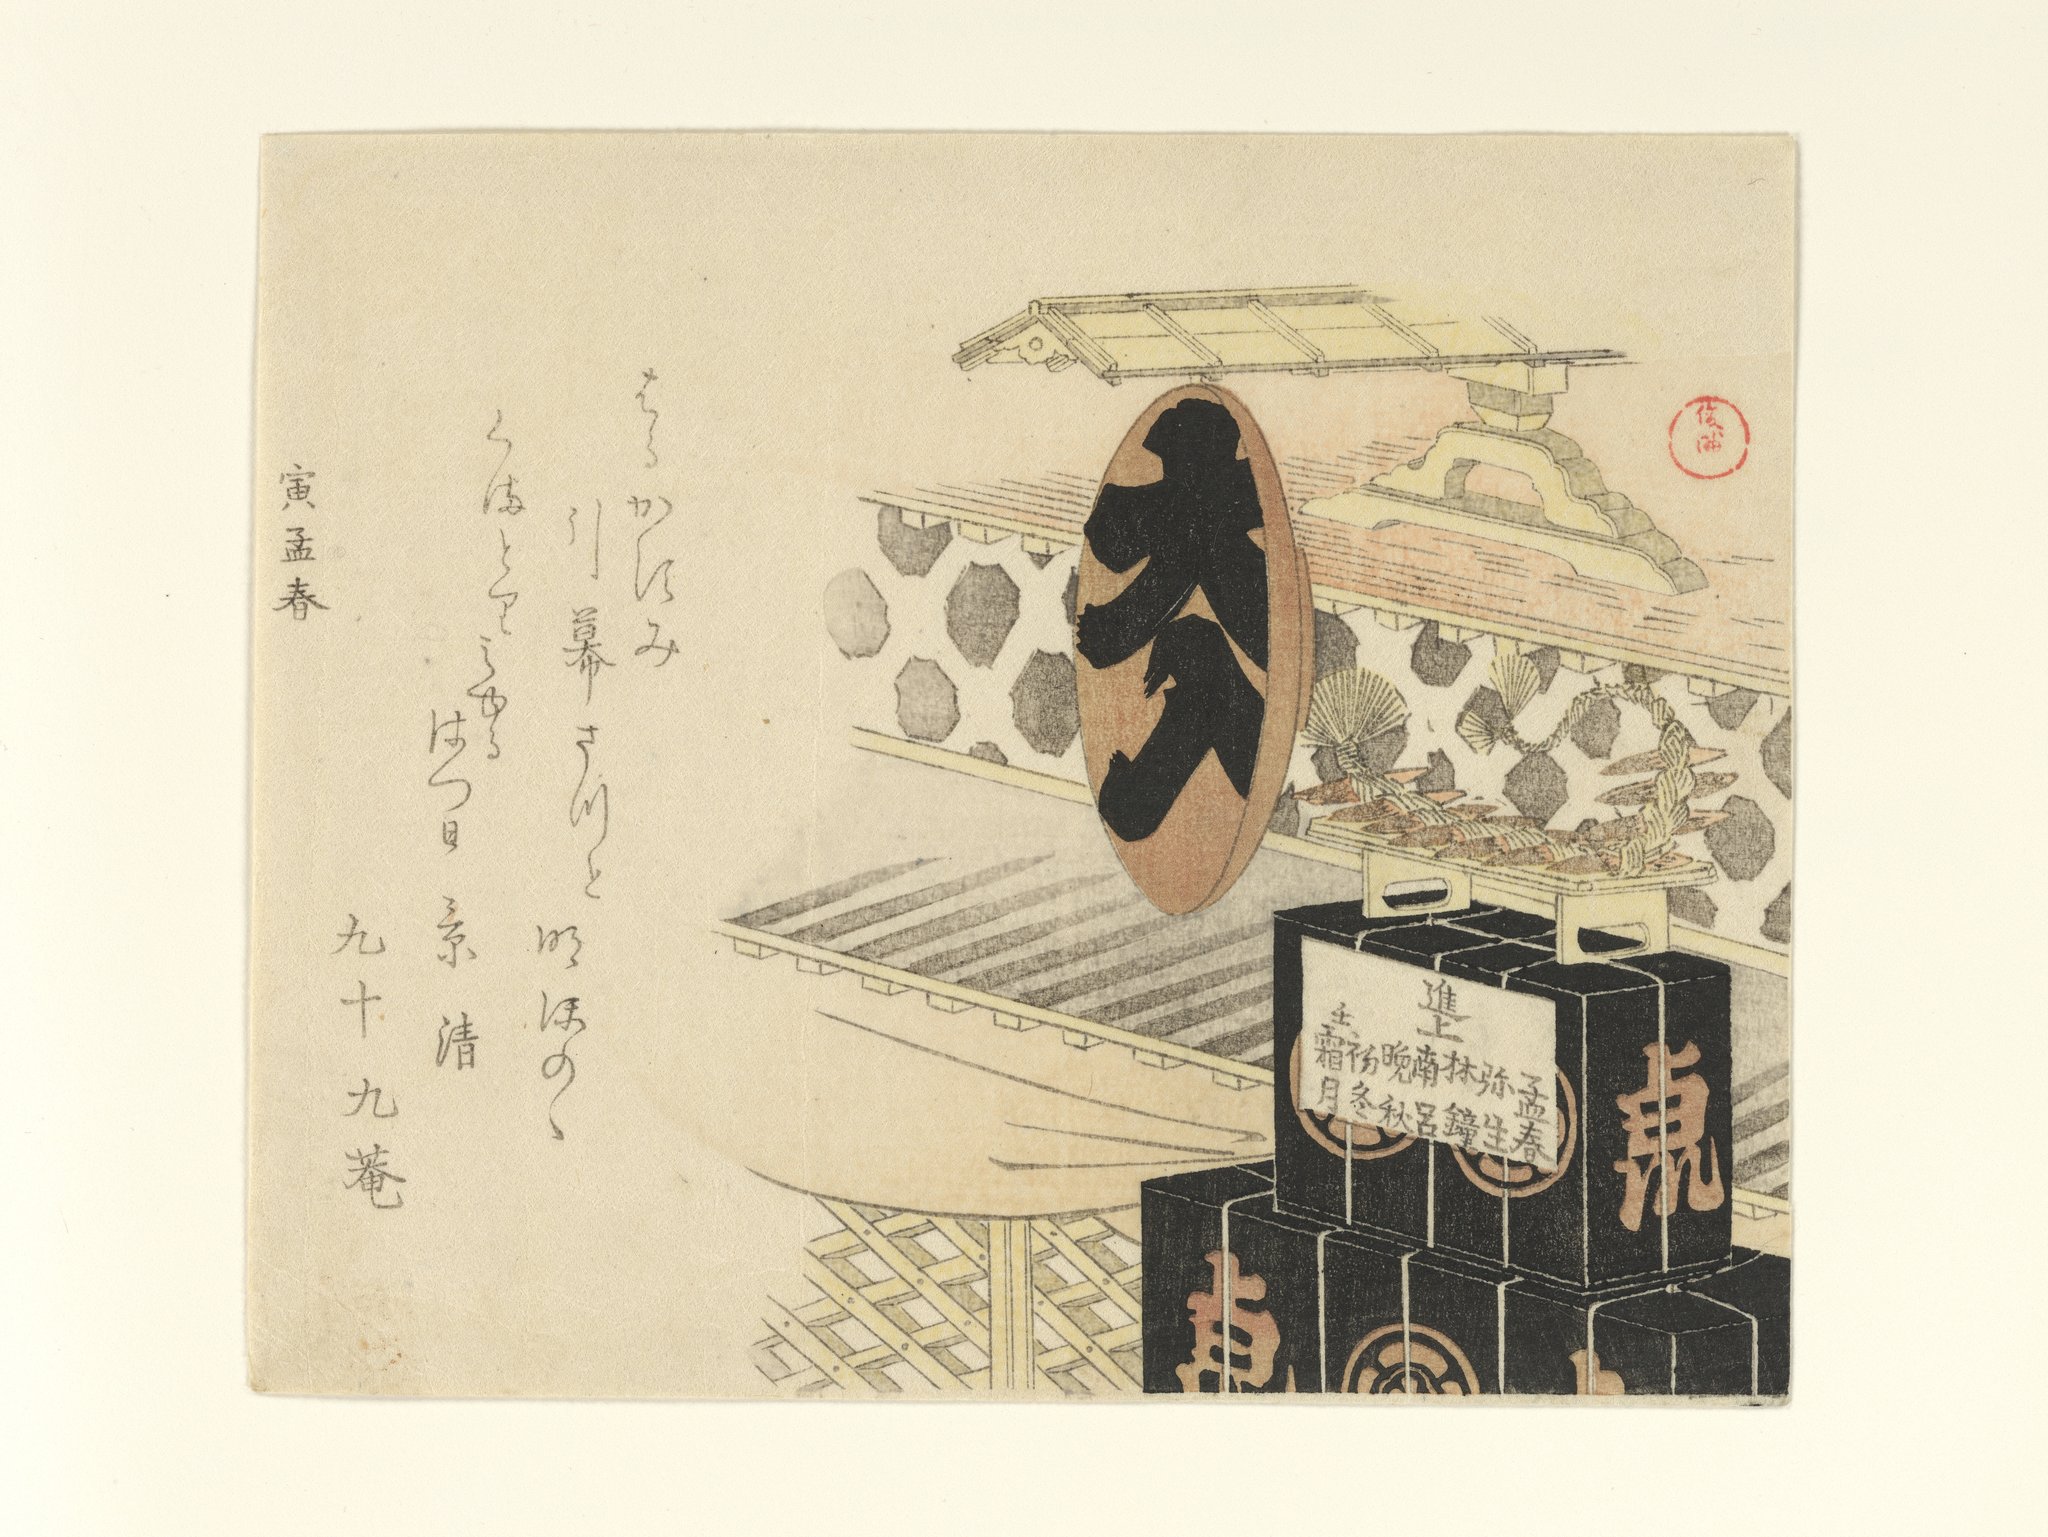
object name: print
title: Large Lacquer Sake Cup Reading "Full House"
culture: japanese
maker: kubo shunman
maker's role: artist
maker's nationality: japanese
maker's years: 1757-1820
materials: ink, paper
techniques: surimono, woodblock print